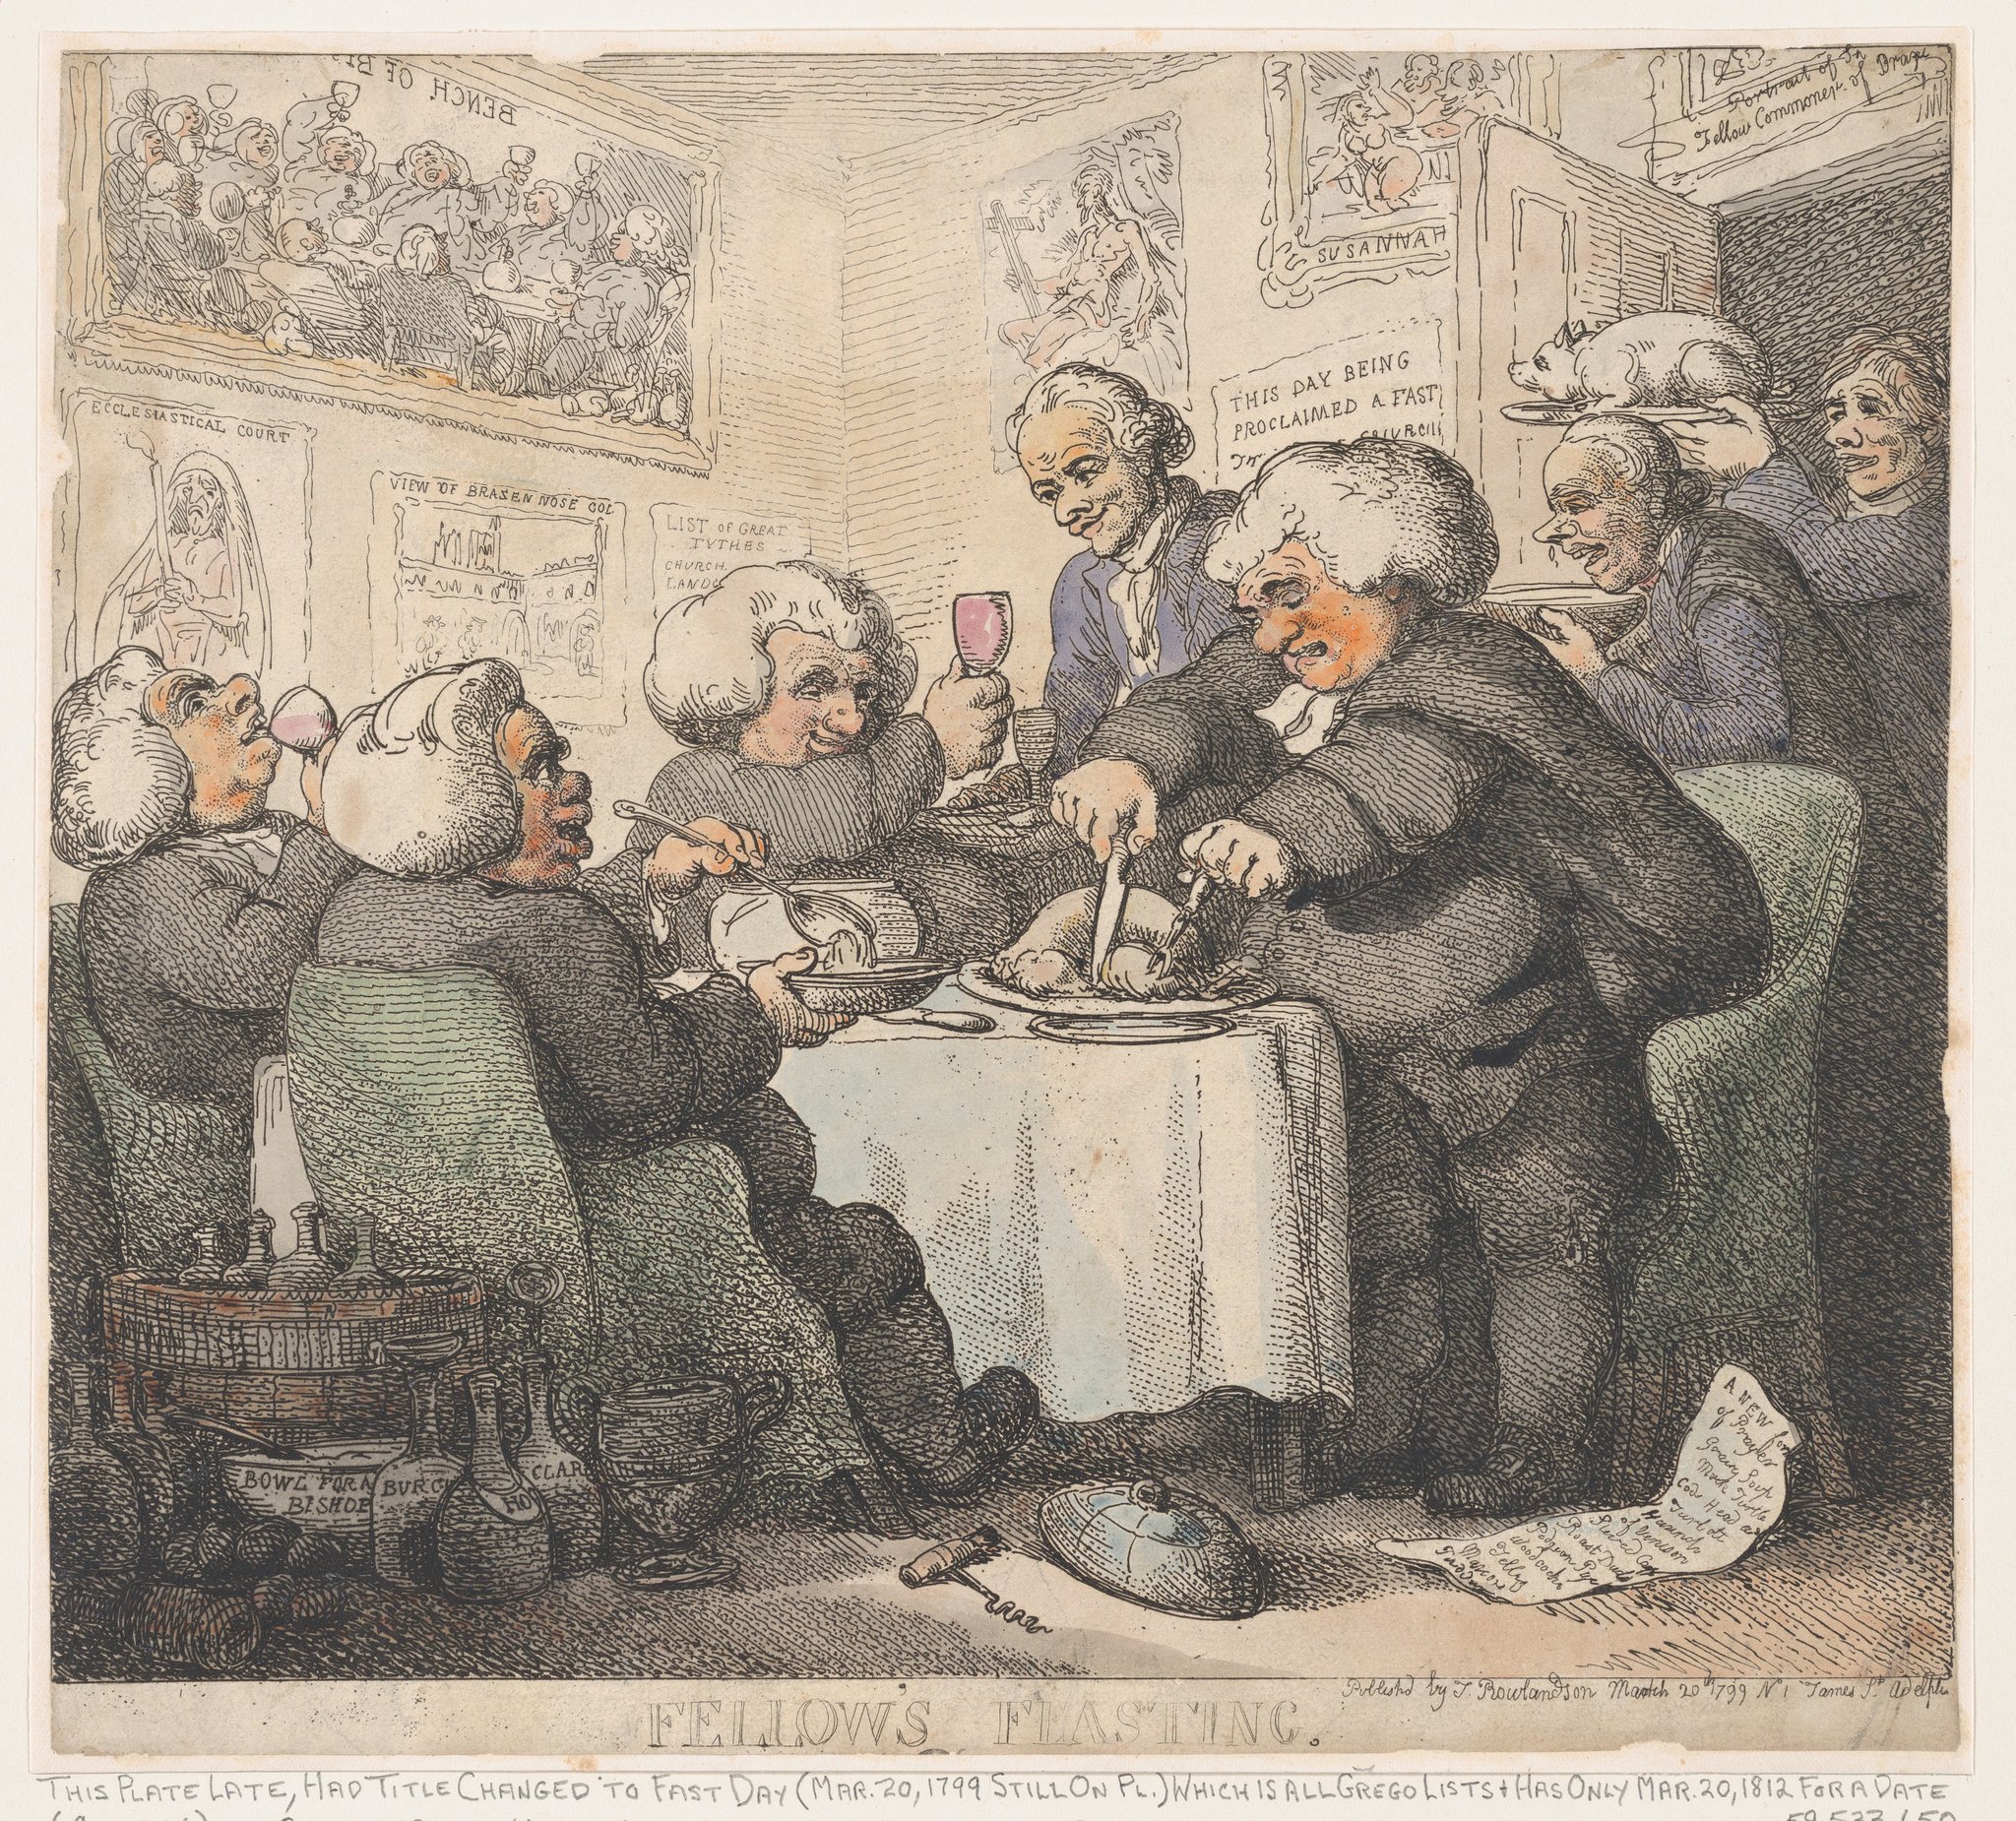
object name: print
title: Fellows Feasting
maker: thomas rowlandson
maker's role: artist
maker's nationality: british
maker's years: 1757-1827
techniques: etching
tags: food,men,dining